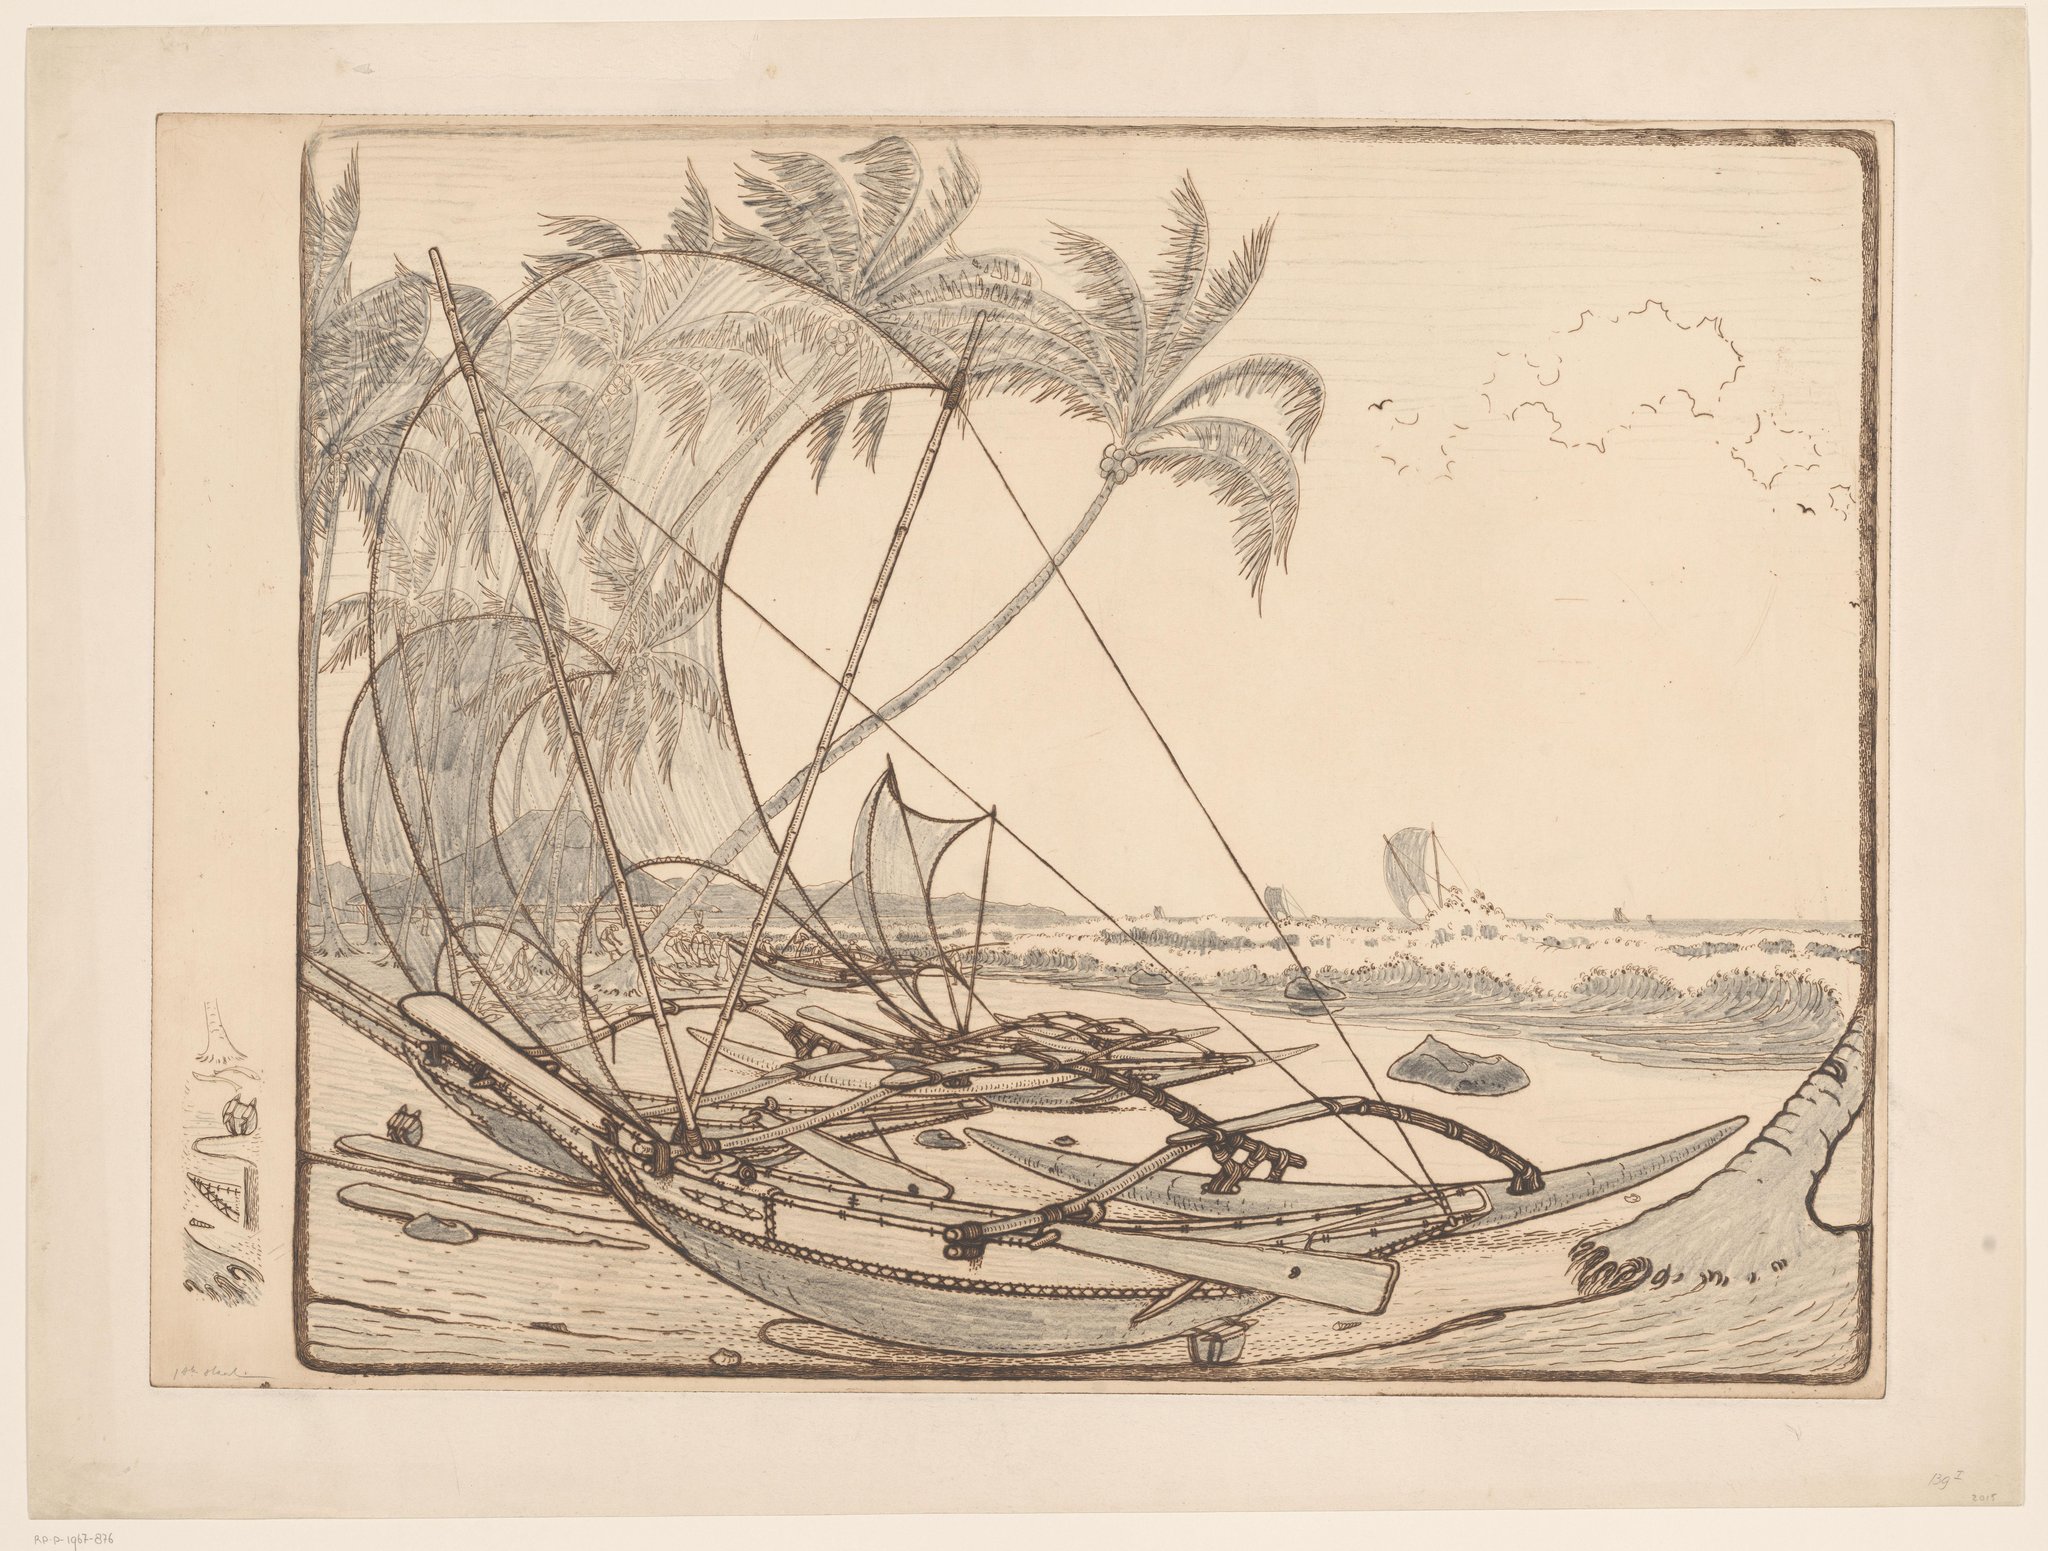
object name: print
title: Zeilen drogen in Colombo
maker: wijnand otto jan nieuwenkamp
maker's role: draughtsman, print maker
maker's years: 1874-1950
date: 1913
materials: paper, pencil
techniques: etching, retroussage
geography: edam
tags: sail, sailing-ship, sailing-boat, ships, boats on land, beached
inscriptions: collector's mark: Lugt 2228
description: Naar schets van 23 januari 1904, gemaakt tijdens oponthoud in Colombo tijdens Nieuwenkamps tweede reis naar Nederlands-Indië.